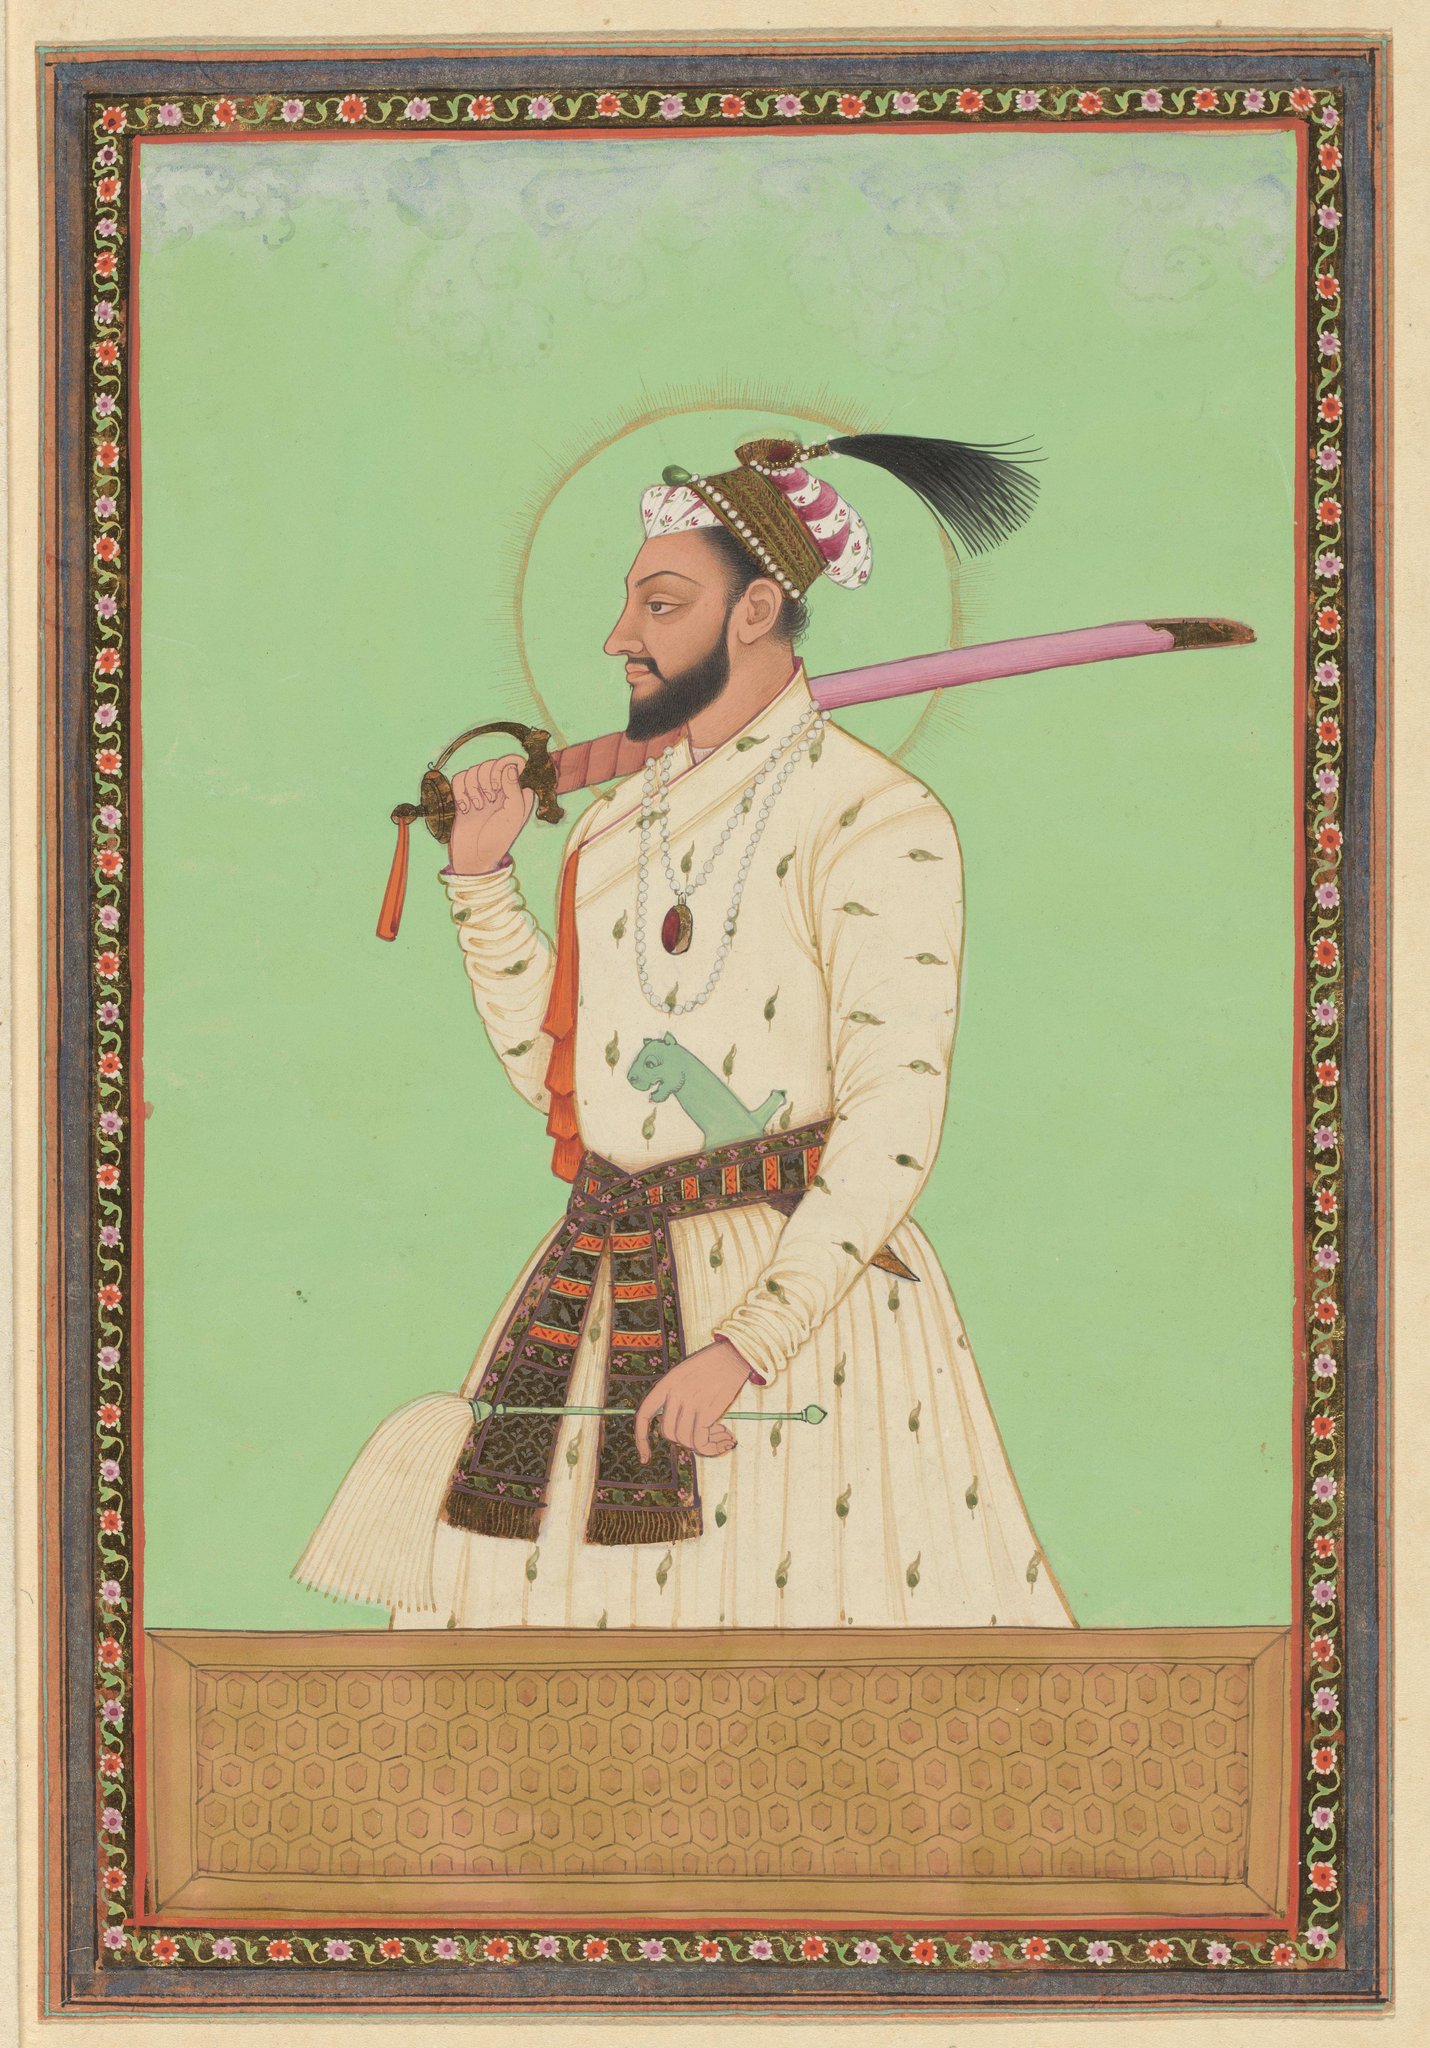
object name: indian miniature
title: Portret van Dara Shikoh, de oudste zoon van Shah Jahan, die in de tijd van zijn vader regeerde over de provincie Delhi; na de dood van zijn vader heeft Aurangzeb hem gedood en is zelf heerser van Delhi geworden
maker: Anonymous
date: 1686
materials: paint, gold leaf, gouache, paper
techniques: brush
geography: golkonda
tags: amsterdam, print maker, nicolaes cornelisz. witsen, historical person (...) - historical person (...) portrayed alone, ruler, sovereign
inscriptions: collector's mark: Lugt 240, annotation: ‘Darascekjouh, Ouste Zoon van Stah Gichan Koning van Dehli of Decam’, collector's mark: Lugt 1838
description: Dara Shikoh is tot aan zijn heupen afgebeeld, naar links gewend, met zijn rechter hand houdt hij zijn zwaard op zijn schouder en in zijn linker hand heeft hij een vliegenkwast. Blad 8 in het `Witsen-Album', met 49 Indiase miniaturen van vorsten. Boven het portret een stukje papier met de naam in het Perzisch. Onder het portret een stukje papier met de naam in het Portugees.